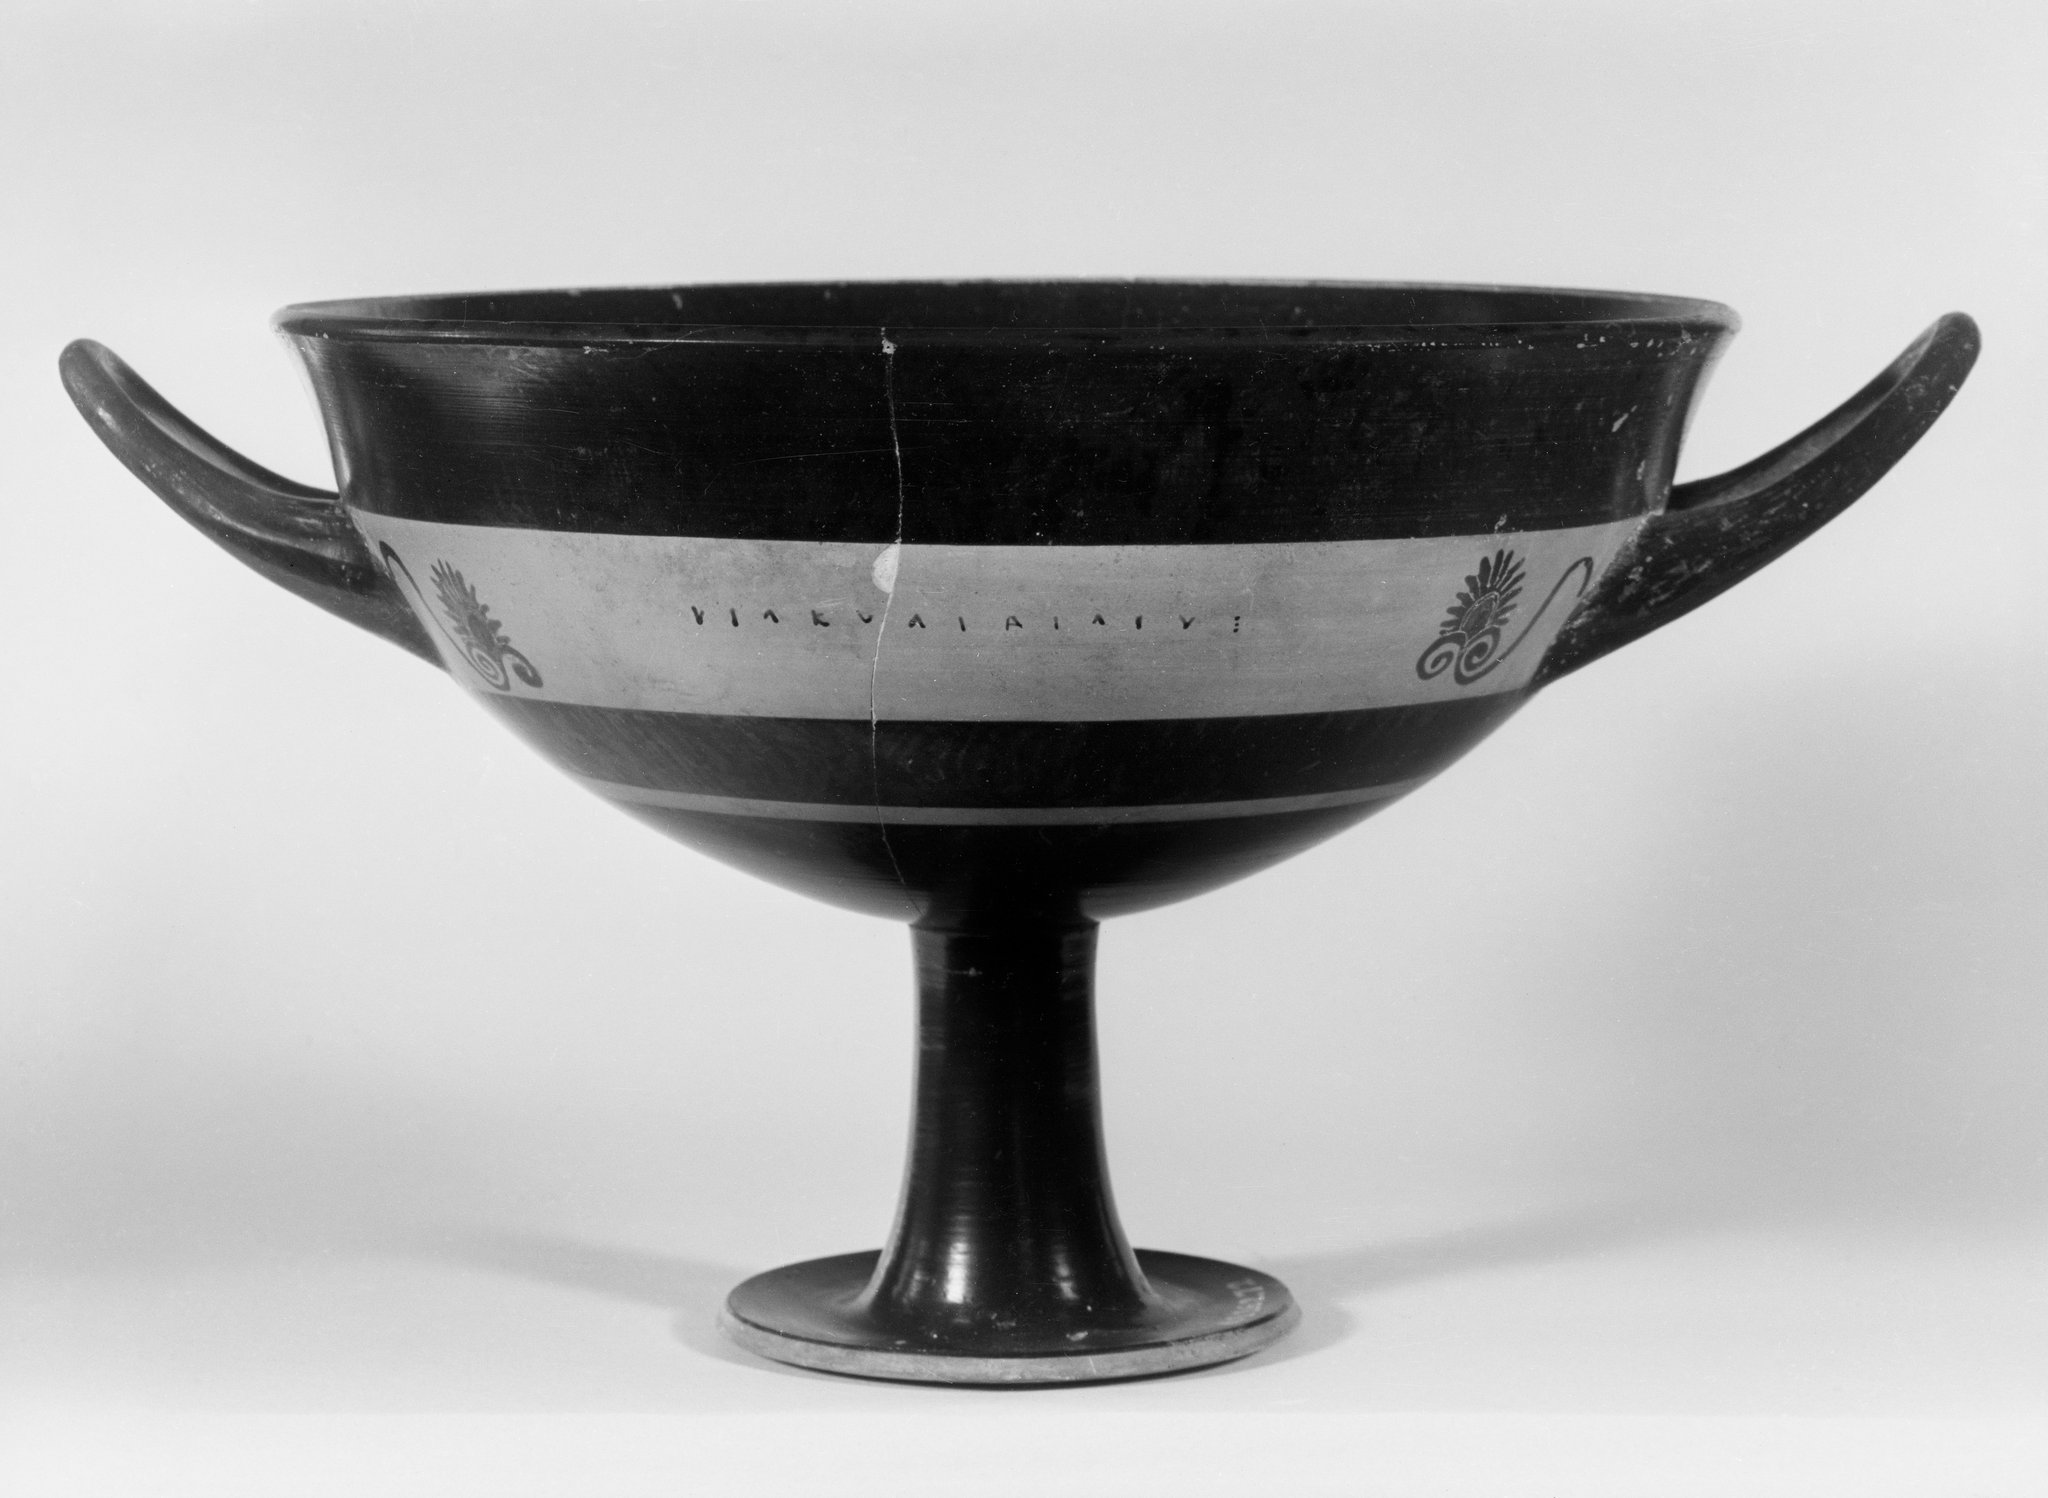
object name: kylix, band cup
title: Kylix, band-cup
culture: greek, attic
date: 550-526 BCE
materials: terracotta